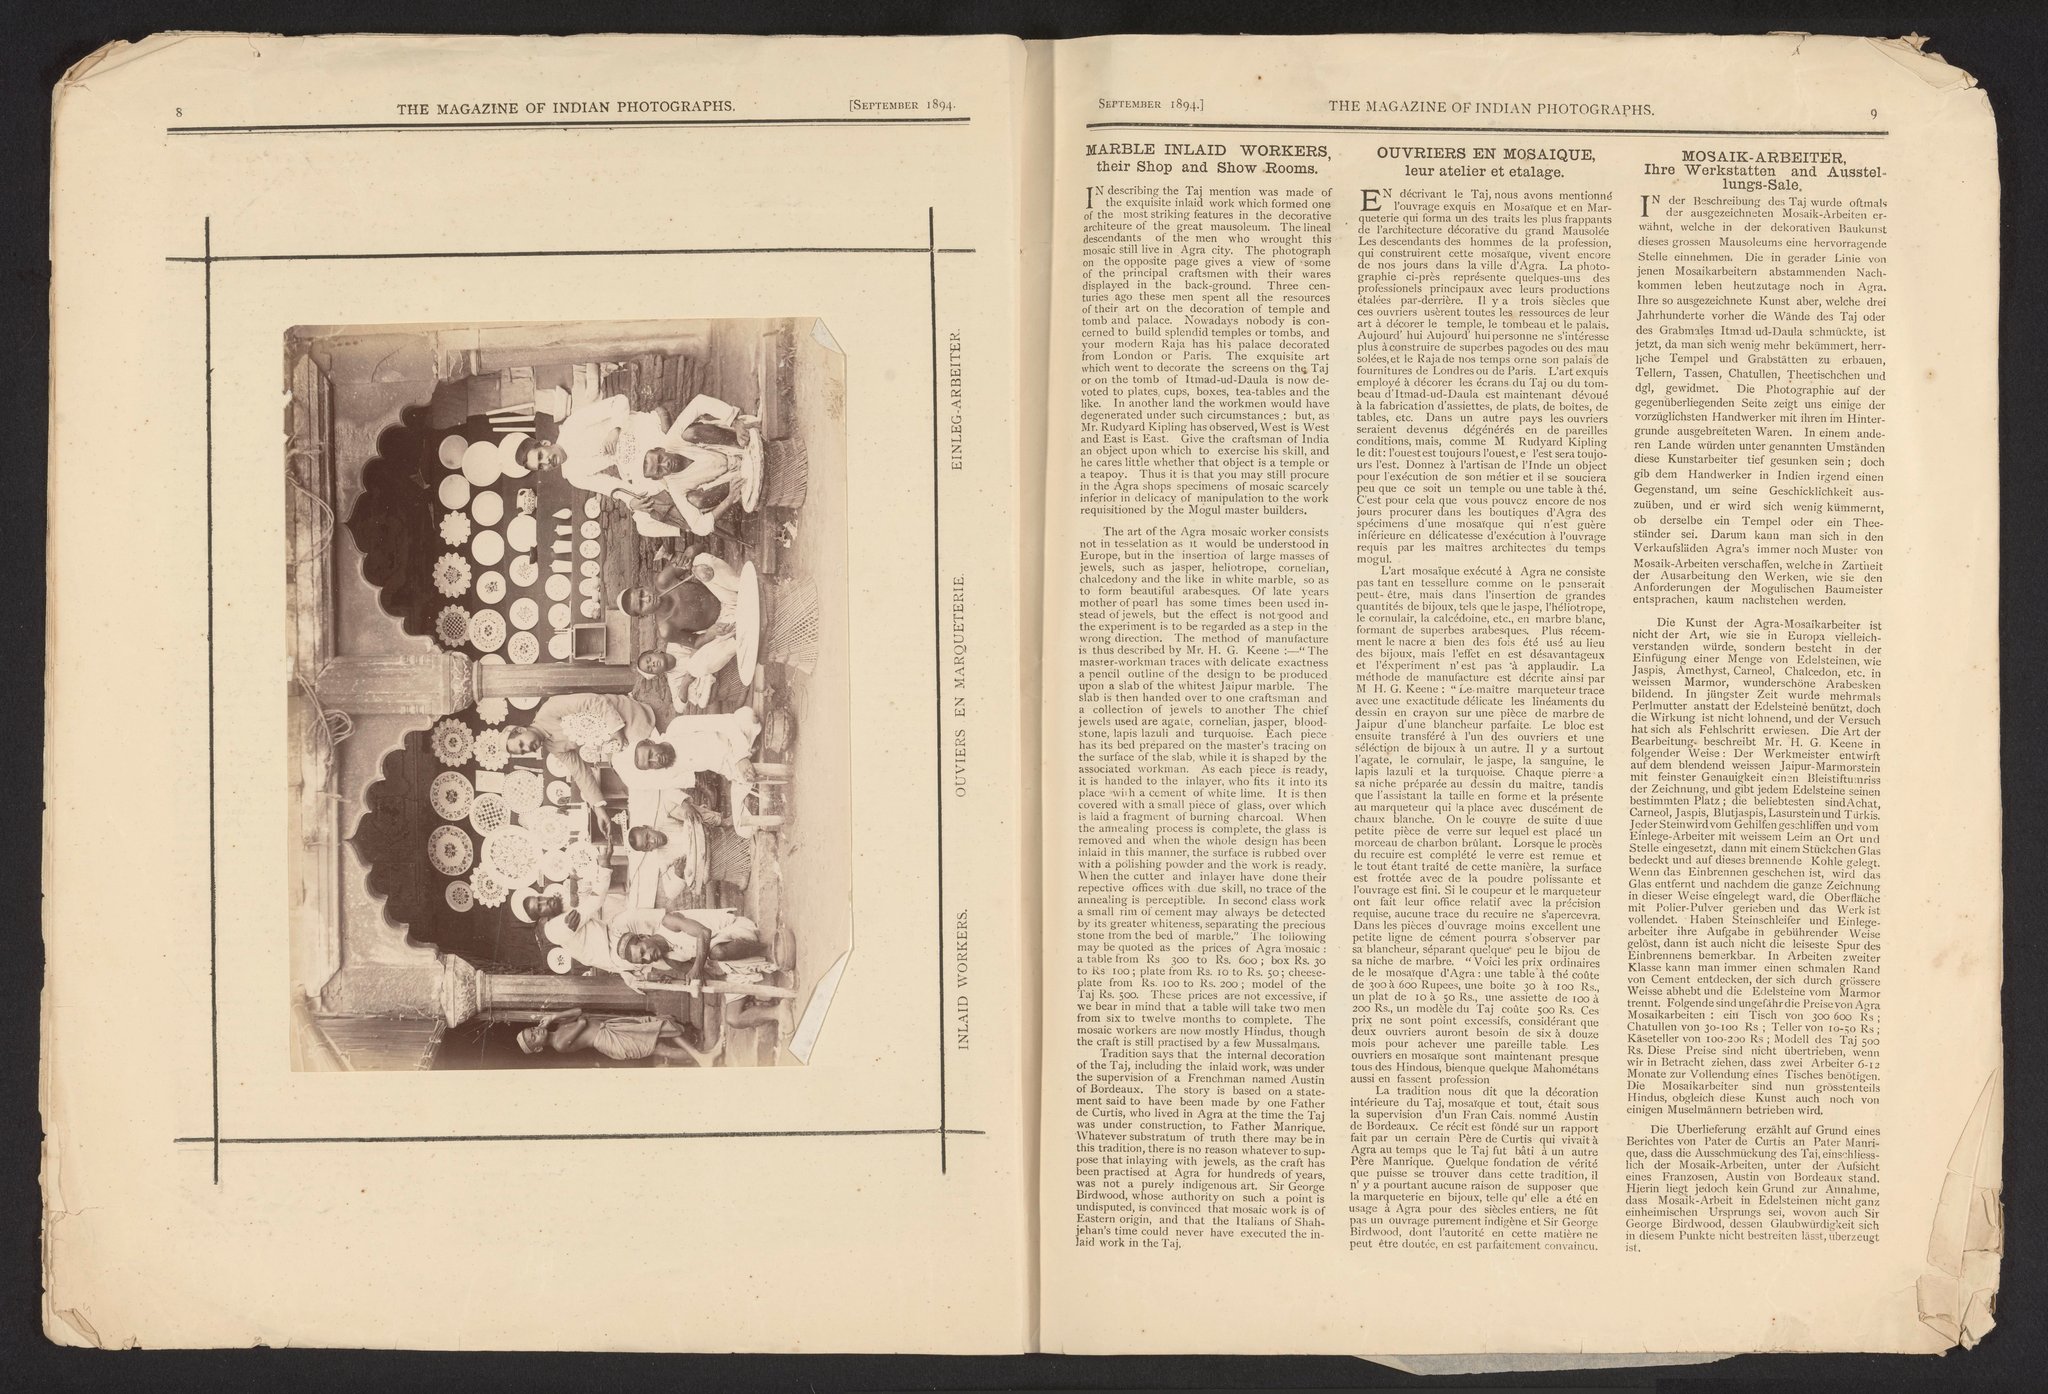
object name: photograph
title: Group portrat of inlay workers at Agra, Uttar Pradesh, India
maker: Anonymous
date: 1889-1894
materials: photographic support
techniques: albumen print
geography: agra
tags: ceramics industry, anonymous historical persons portrayed in a group, in a group-portrait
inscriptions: title: ‘INLAID WORKERS. OUVERS EN MARQUETERIE. EINLEG-ARBEITER.’